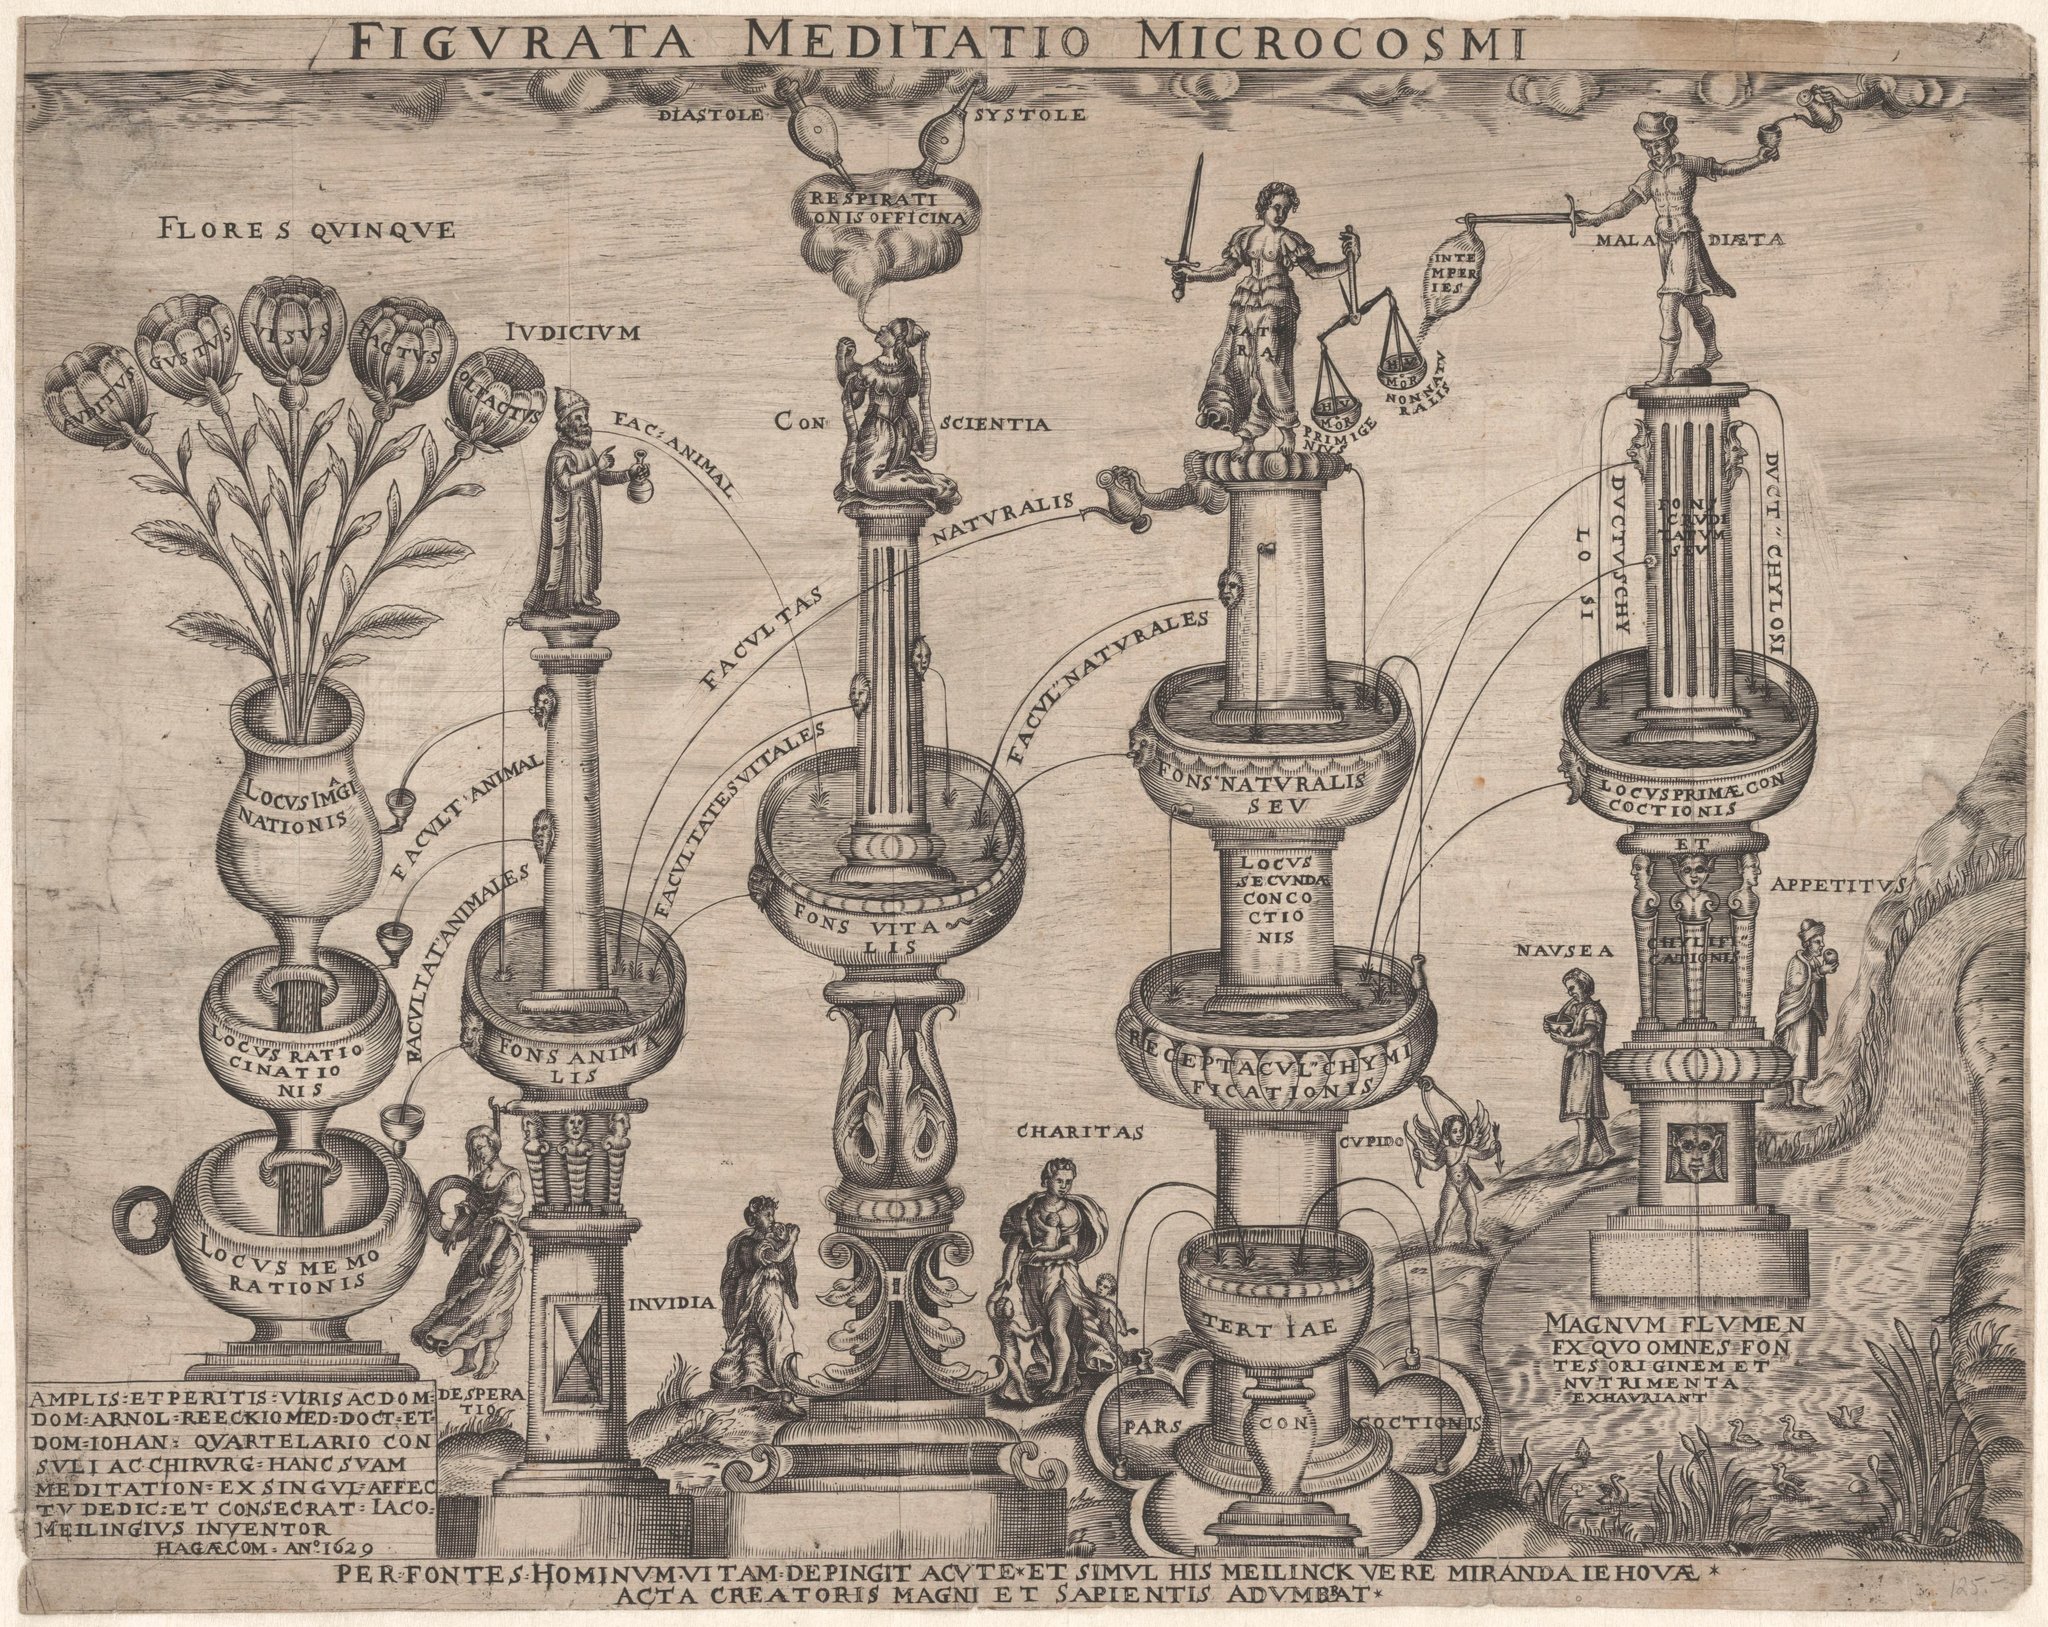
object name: print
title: Figurata Meditatio Microcosmi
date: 1629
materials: paper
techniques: engraving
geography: the hague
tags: christian doctrine, microcosmos ~ macrocosmos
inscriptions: collector's mark: Lugt 2760, collector's mark: Lugt 2228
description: Allegorische weergave van de natuur en de menselijke natuur (microcosmos). Schematische voorstelling met een fontein van de natuur en vier fonteinen van de mens.